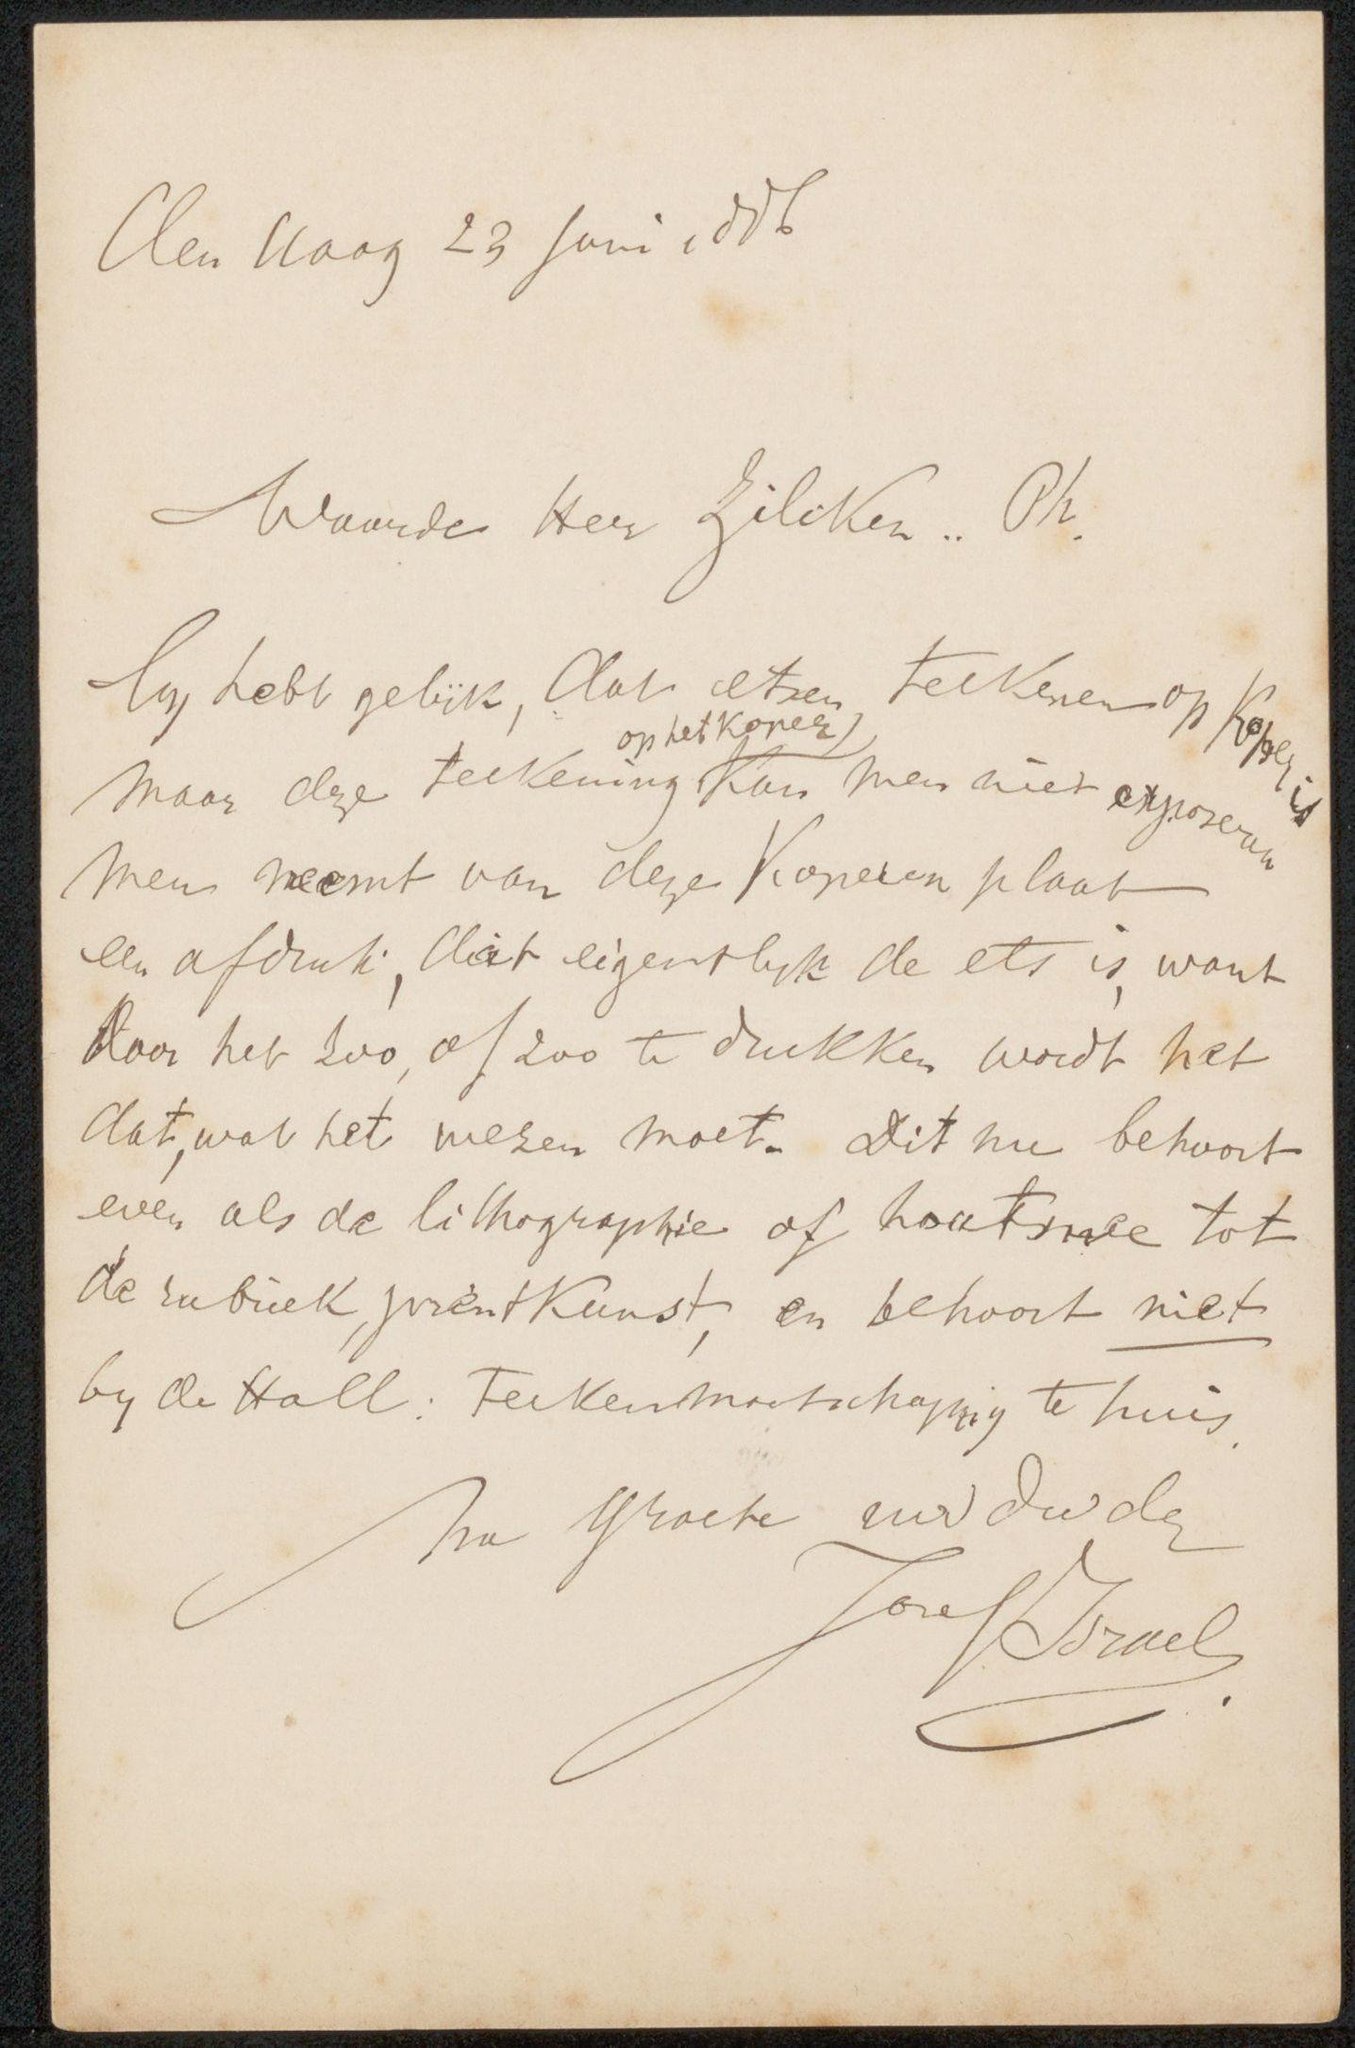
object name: letter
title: Brief aan Philip Zilcken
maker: jozef israëls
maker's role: draughtsman, painter, print maker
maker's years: 1824-1911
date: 1886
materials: ink, paper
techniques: pen, writing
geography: the hague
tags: the hague, painter, draughtsman, philip zilcken, the graphic arts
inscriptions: collector's mark: ‘RPK’